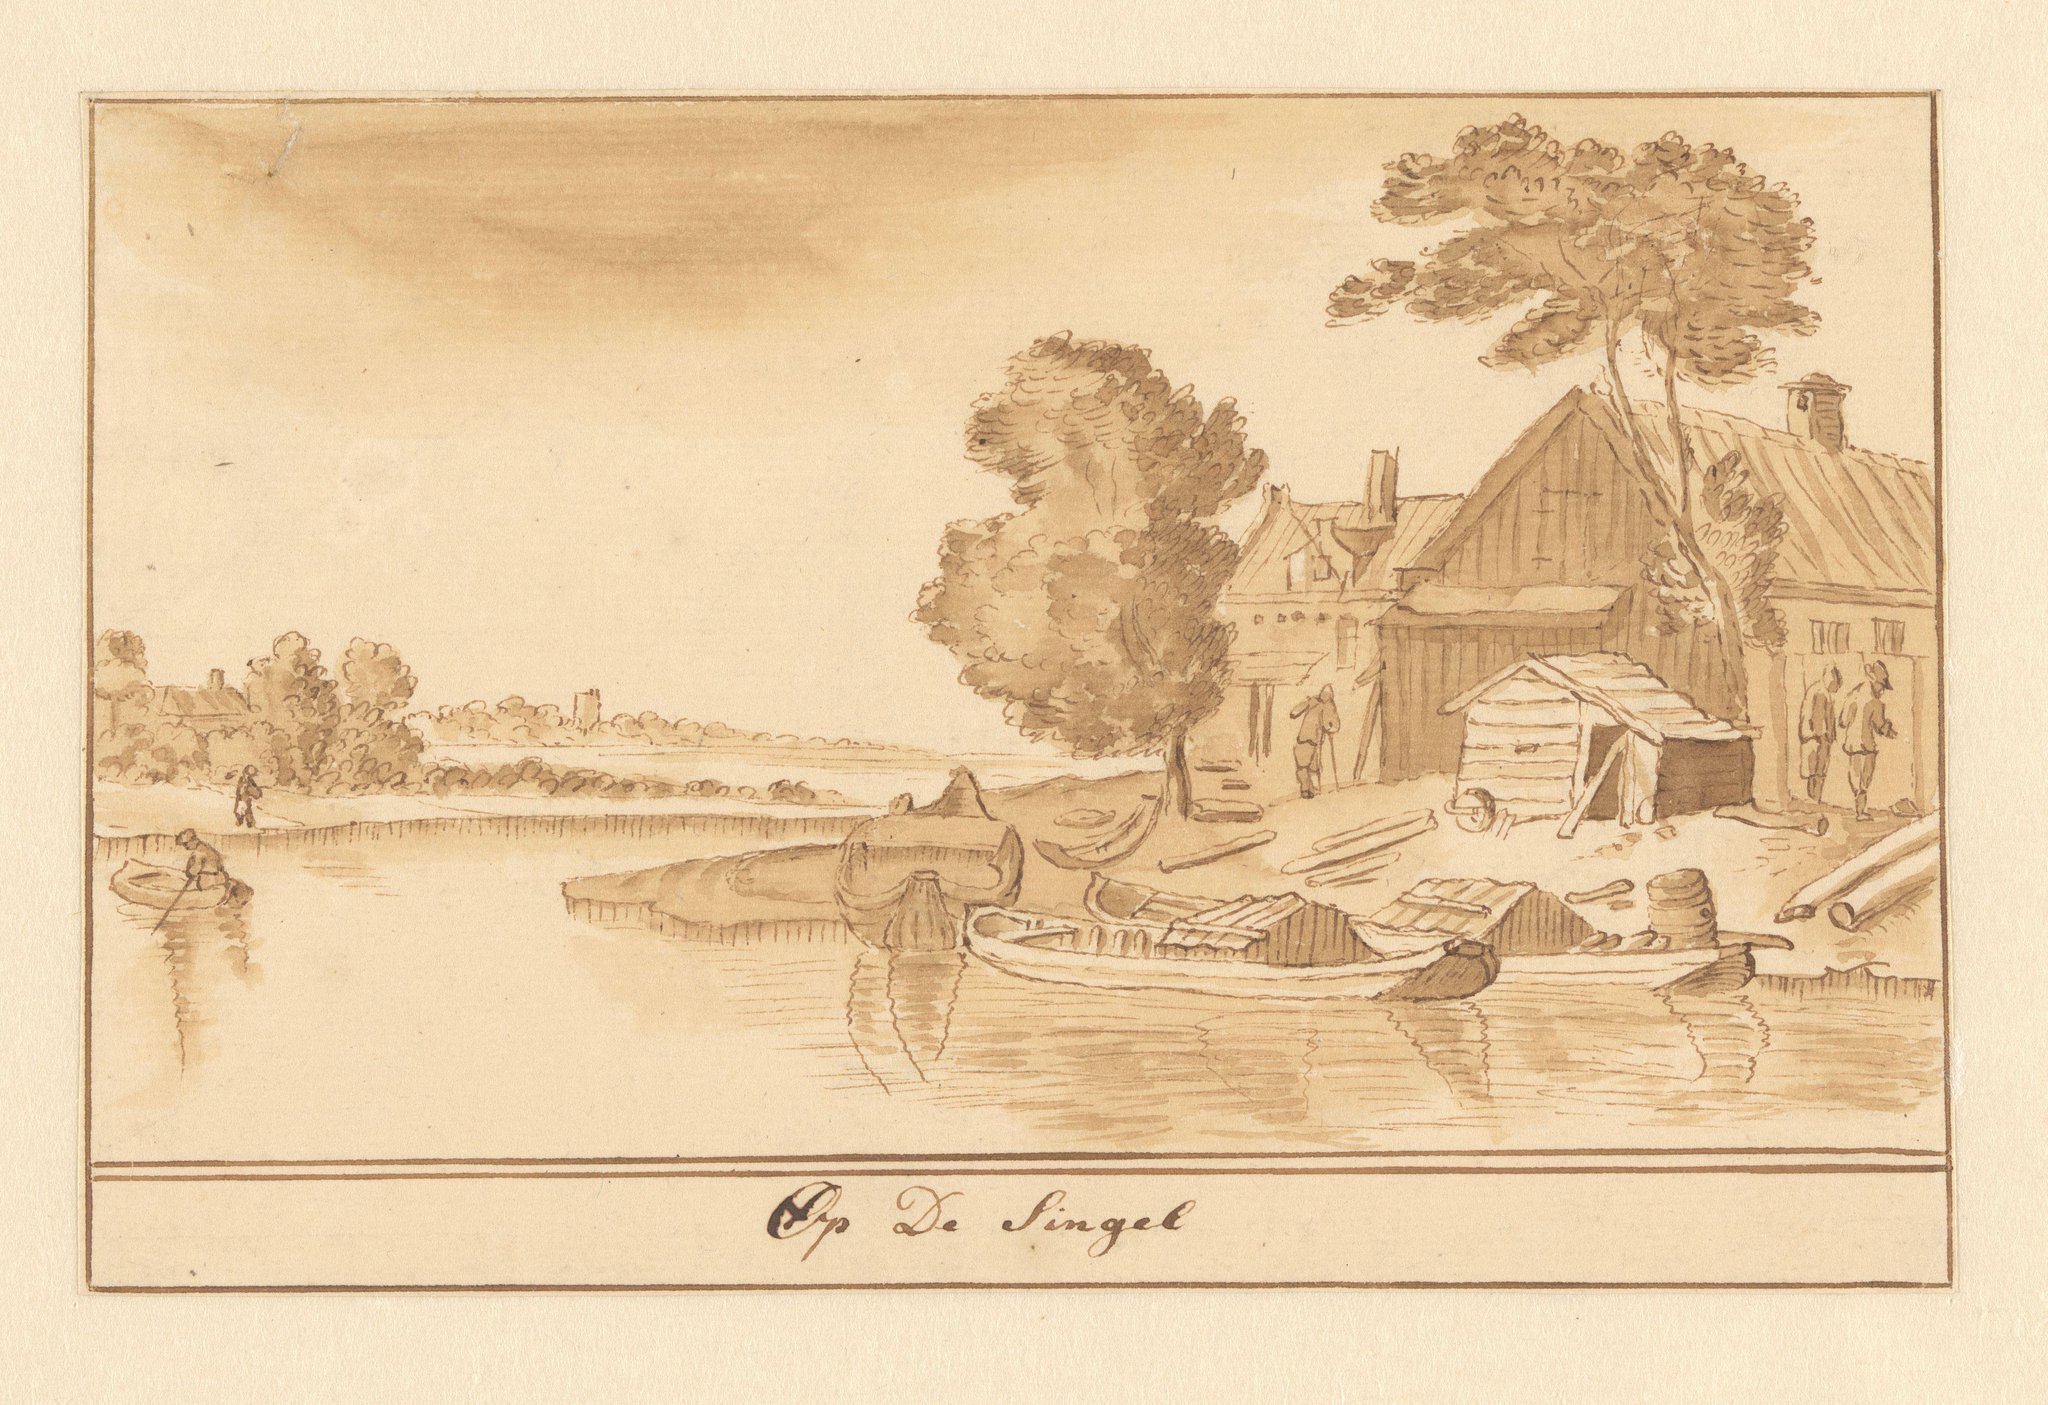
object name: drawing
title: Rivierlandschap met gezicht op de Singel (?)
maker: Anonymous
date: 1700-1800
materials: ink, paper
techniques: brush, pen